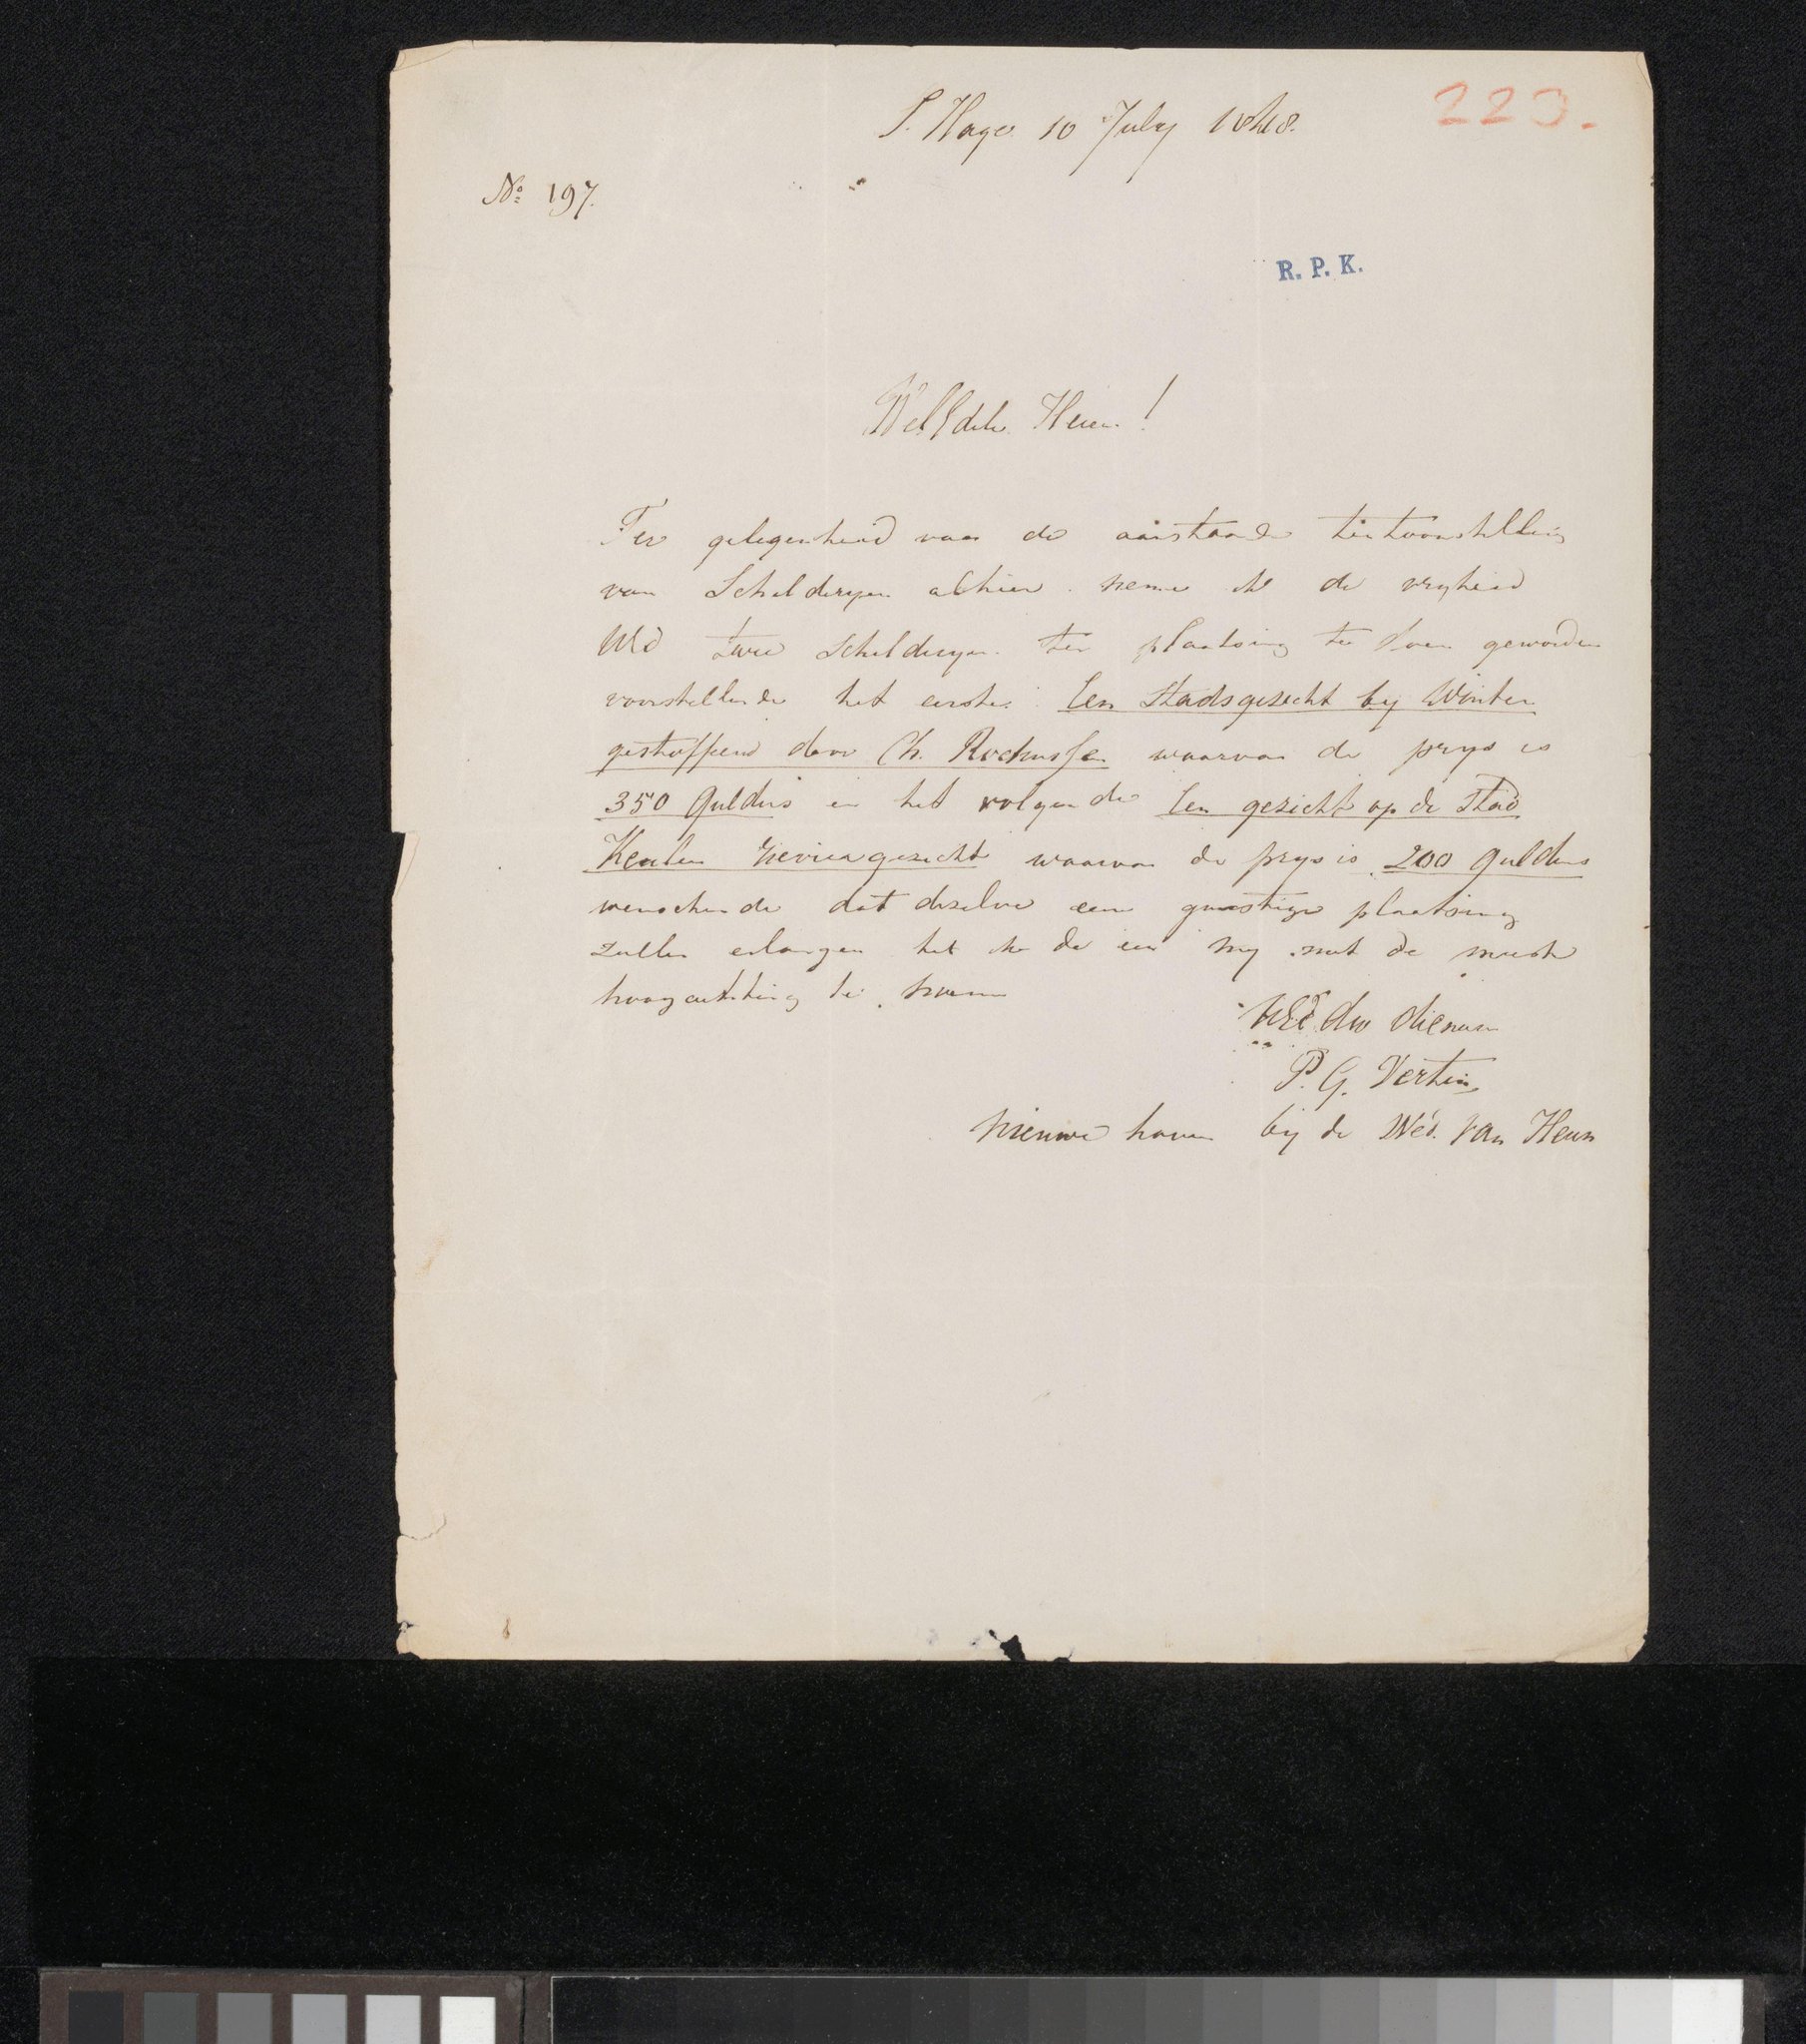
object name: letter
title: Brief aan de Commissie van de Tentoonstelling van Levende Meesters in Den Haag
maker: petrus gerardus vertin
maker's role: draughtsman, painter, print maker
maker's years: 1819-1893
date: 1848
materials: ink, paper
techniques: pen, writing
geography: the hague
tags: charles rochussen, painting (including book-illumination, miniature-painting), exhibition ~ art, money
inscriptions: collector's mark: Lugt 2233